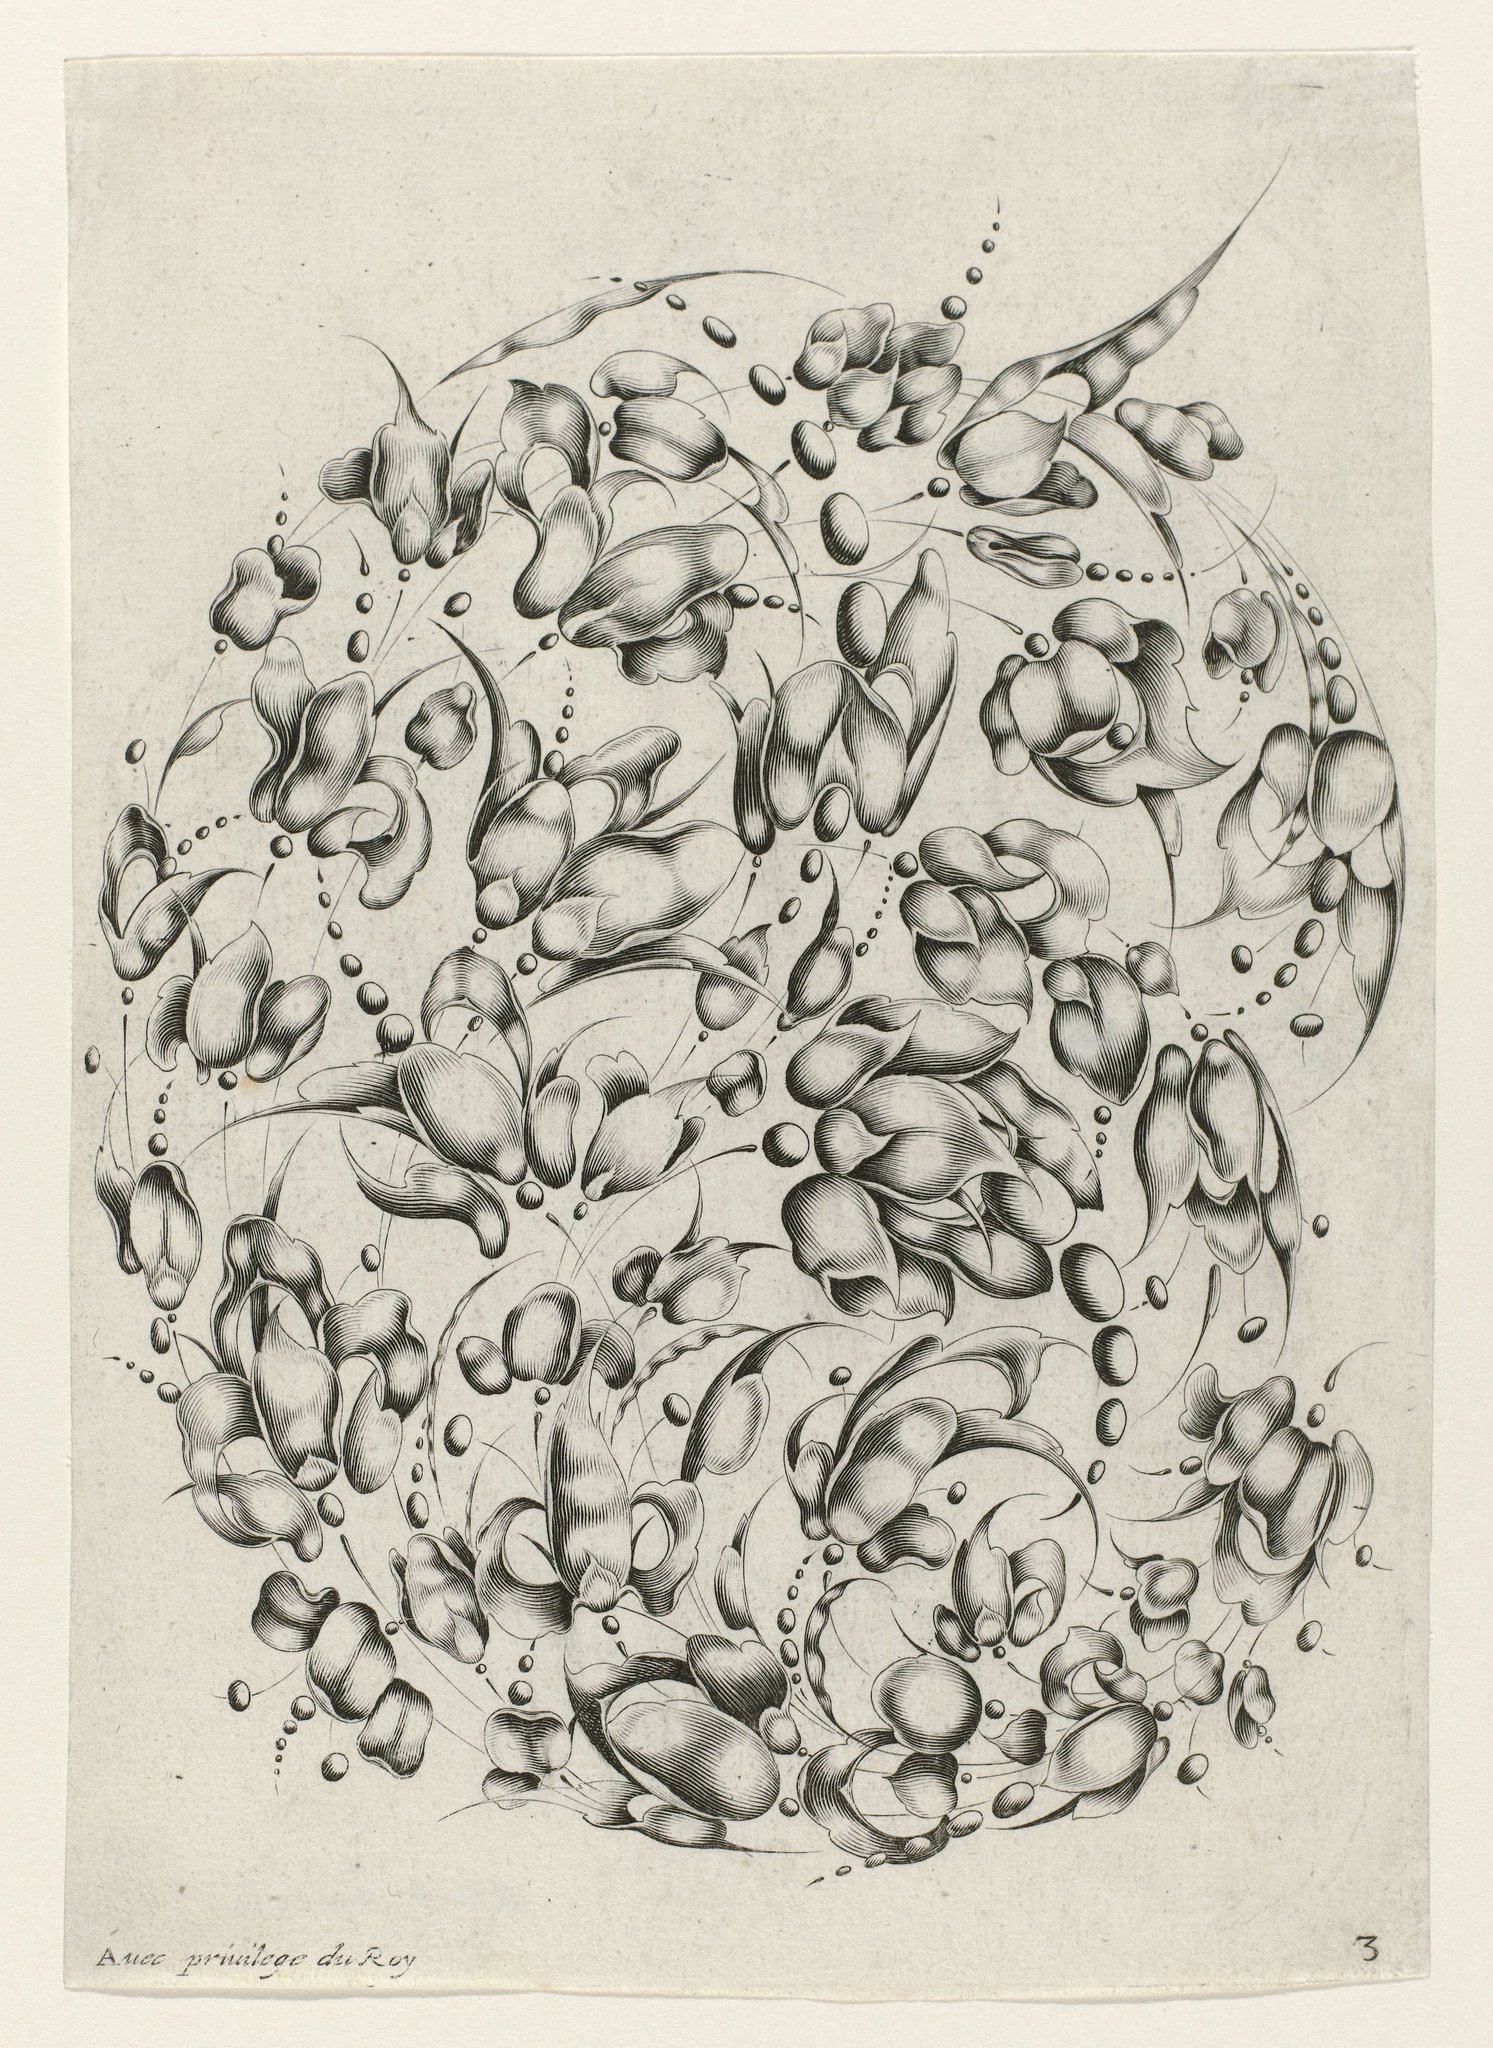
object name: print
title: Livre de toutes sortes de feuilles pour servir a l'art d'orfeburie. Serie van zes genummerde gravures met cosse-de-poisornamenten voor goudsmeden.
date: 1627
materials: paper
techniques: etching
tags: ornament derived from plant forms